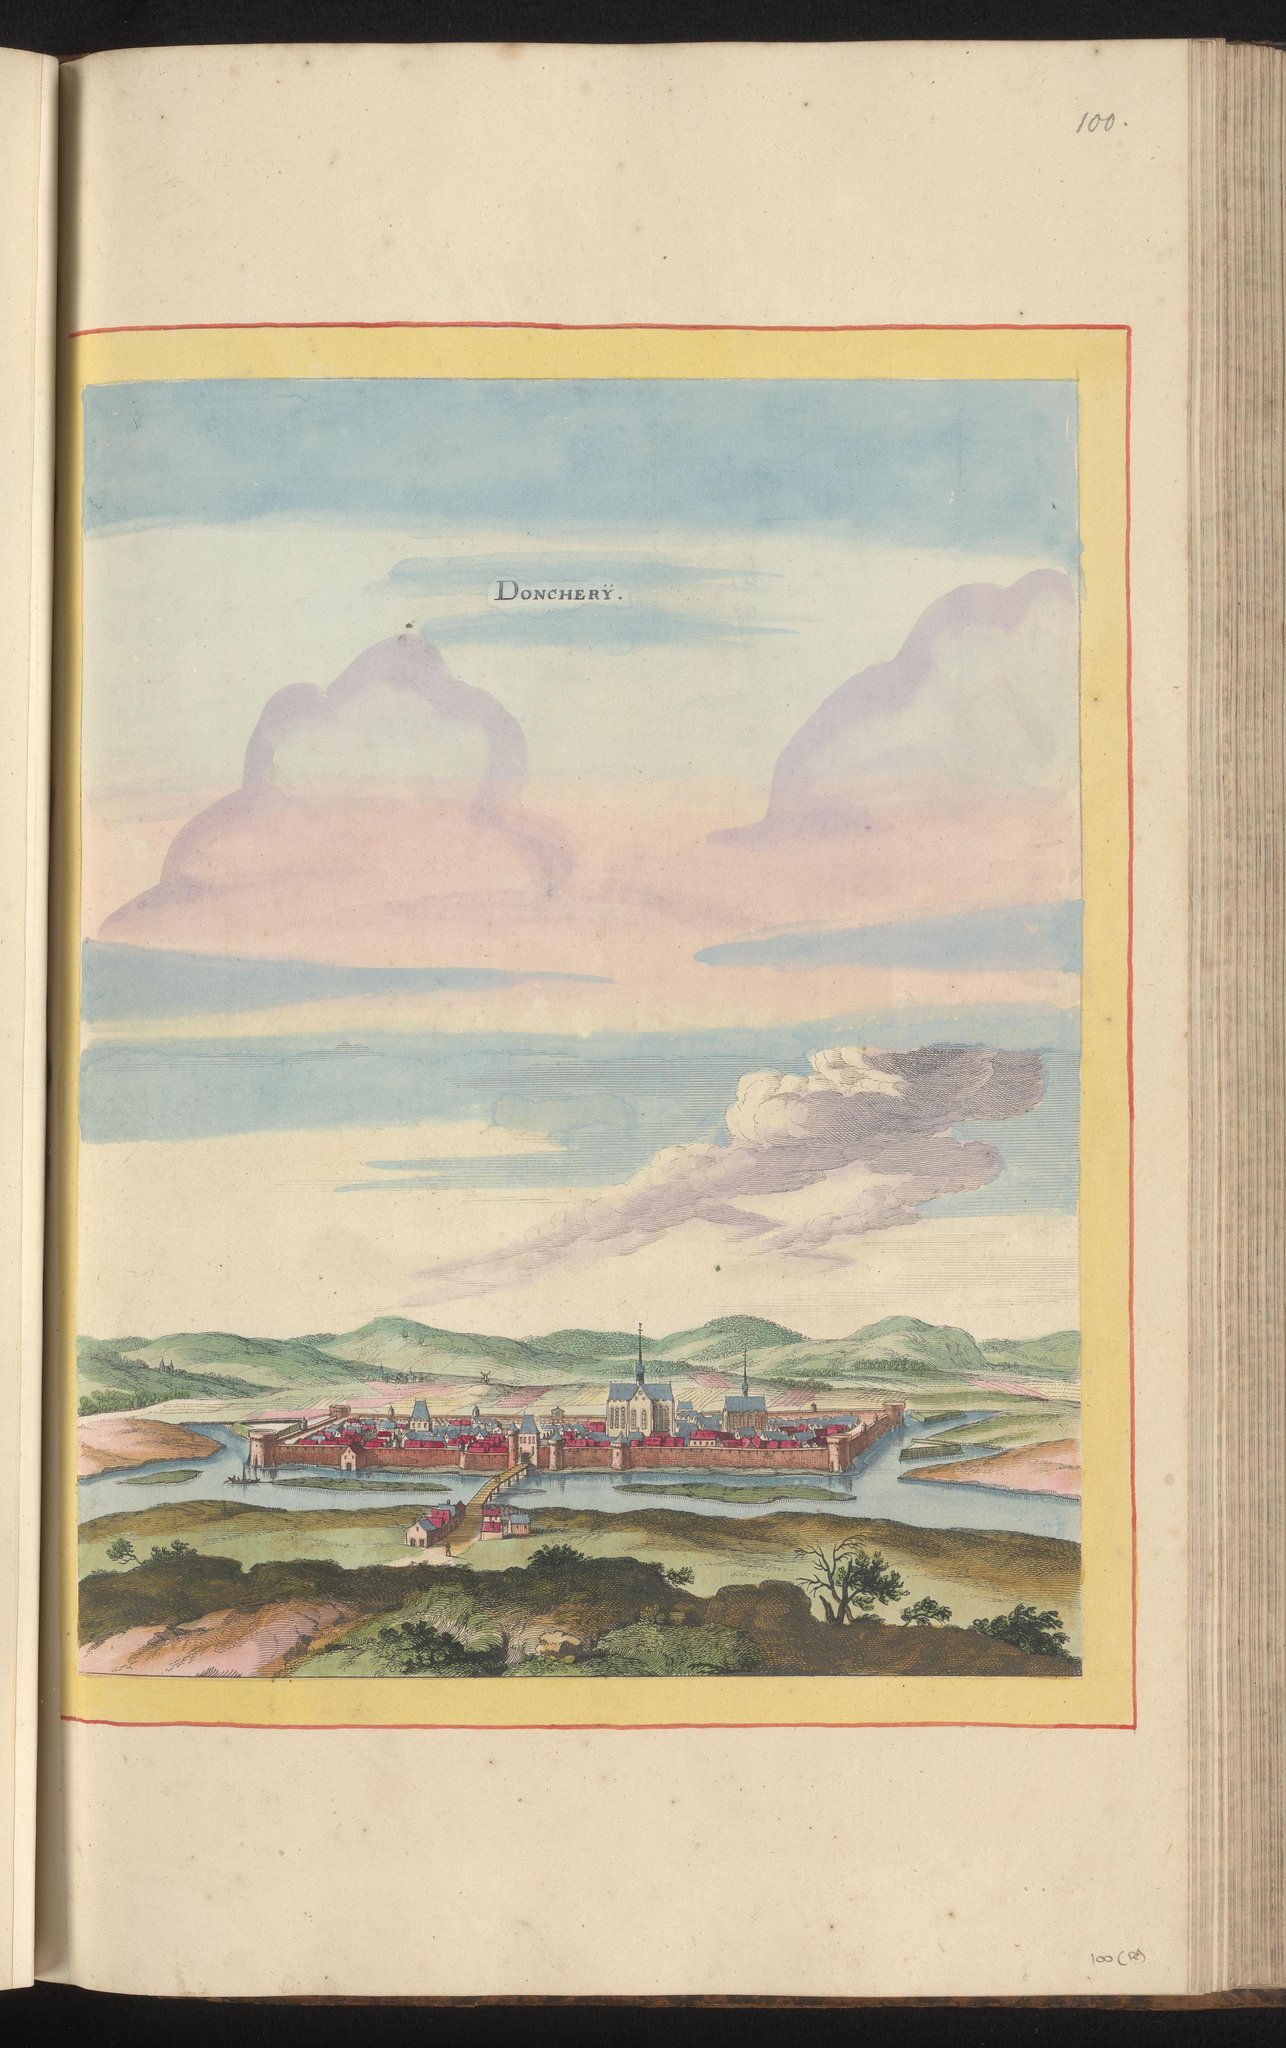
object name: print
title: Doncherÿ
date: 1656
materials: paper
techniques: engraving, etching, hand coloring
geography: the hague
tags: city-view in general; 'veduta'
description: Prent uit: Zeiller, Martin. Topographia Galliae. 13 dln. Frankfurt: Caspar Merian, 1656, dl. 3, na p. 12.